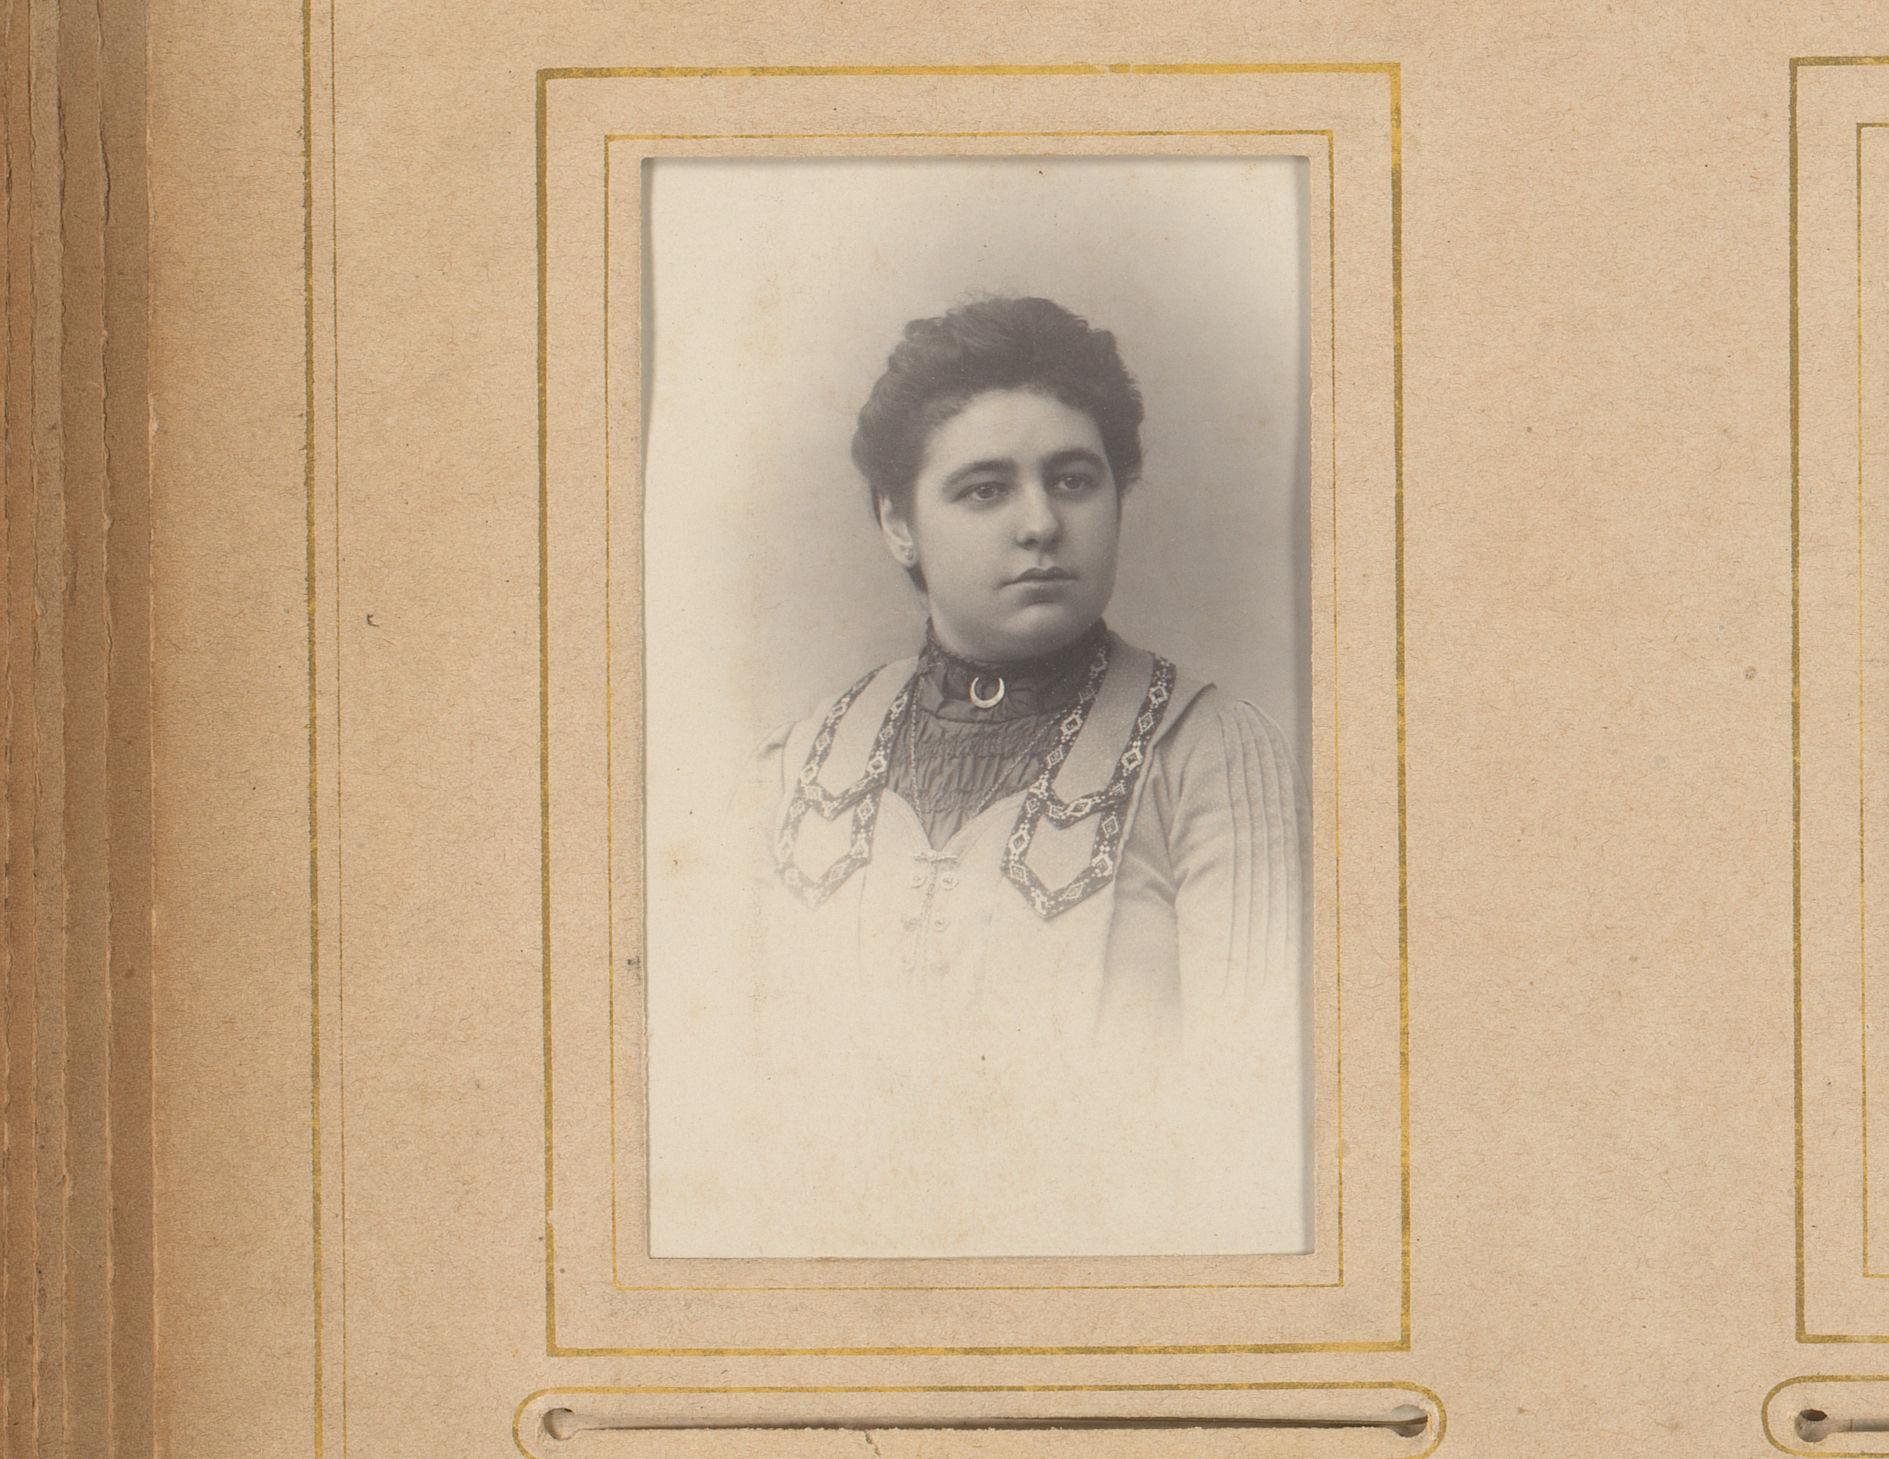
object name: photograph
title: Portret van een vrouw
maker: charles de latin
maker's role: fotograaf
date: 1880-1915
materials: cardboard, photographic support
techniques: gelatin silver print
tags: adult woman, historical persons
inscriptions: inscription: ‘Atelier/ Ch. de Latin/ 34 Kroonstraat/ rue de la Couronne (...)’, name: ‘Ch. de Latin Borgerhout/ 34 Kroonstraat’